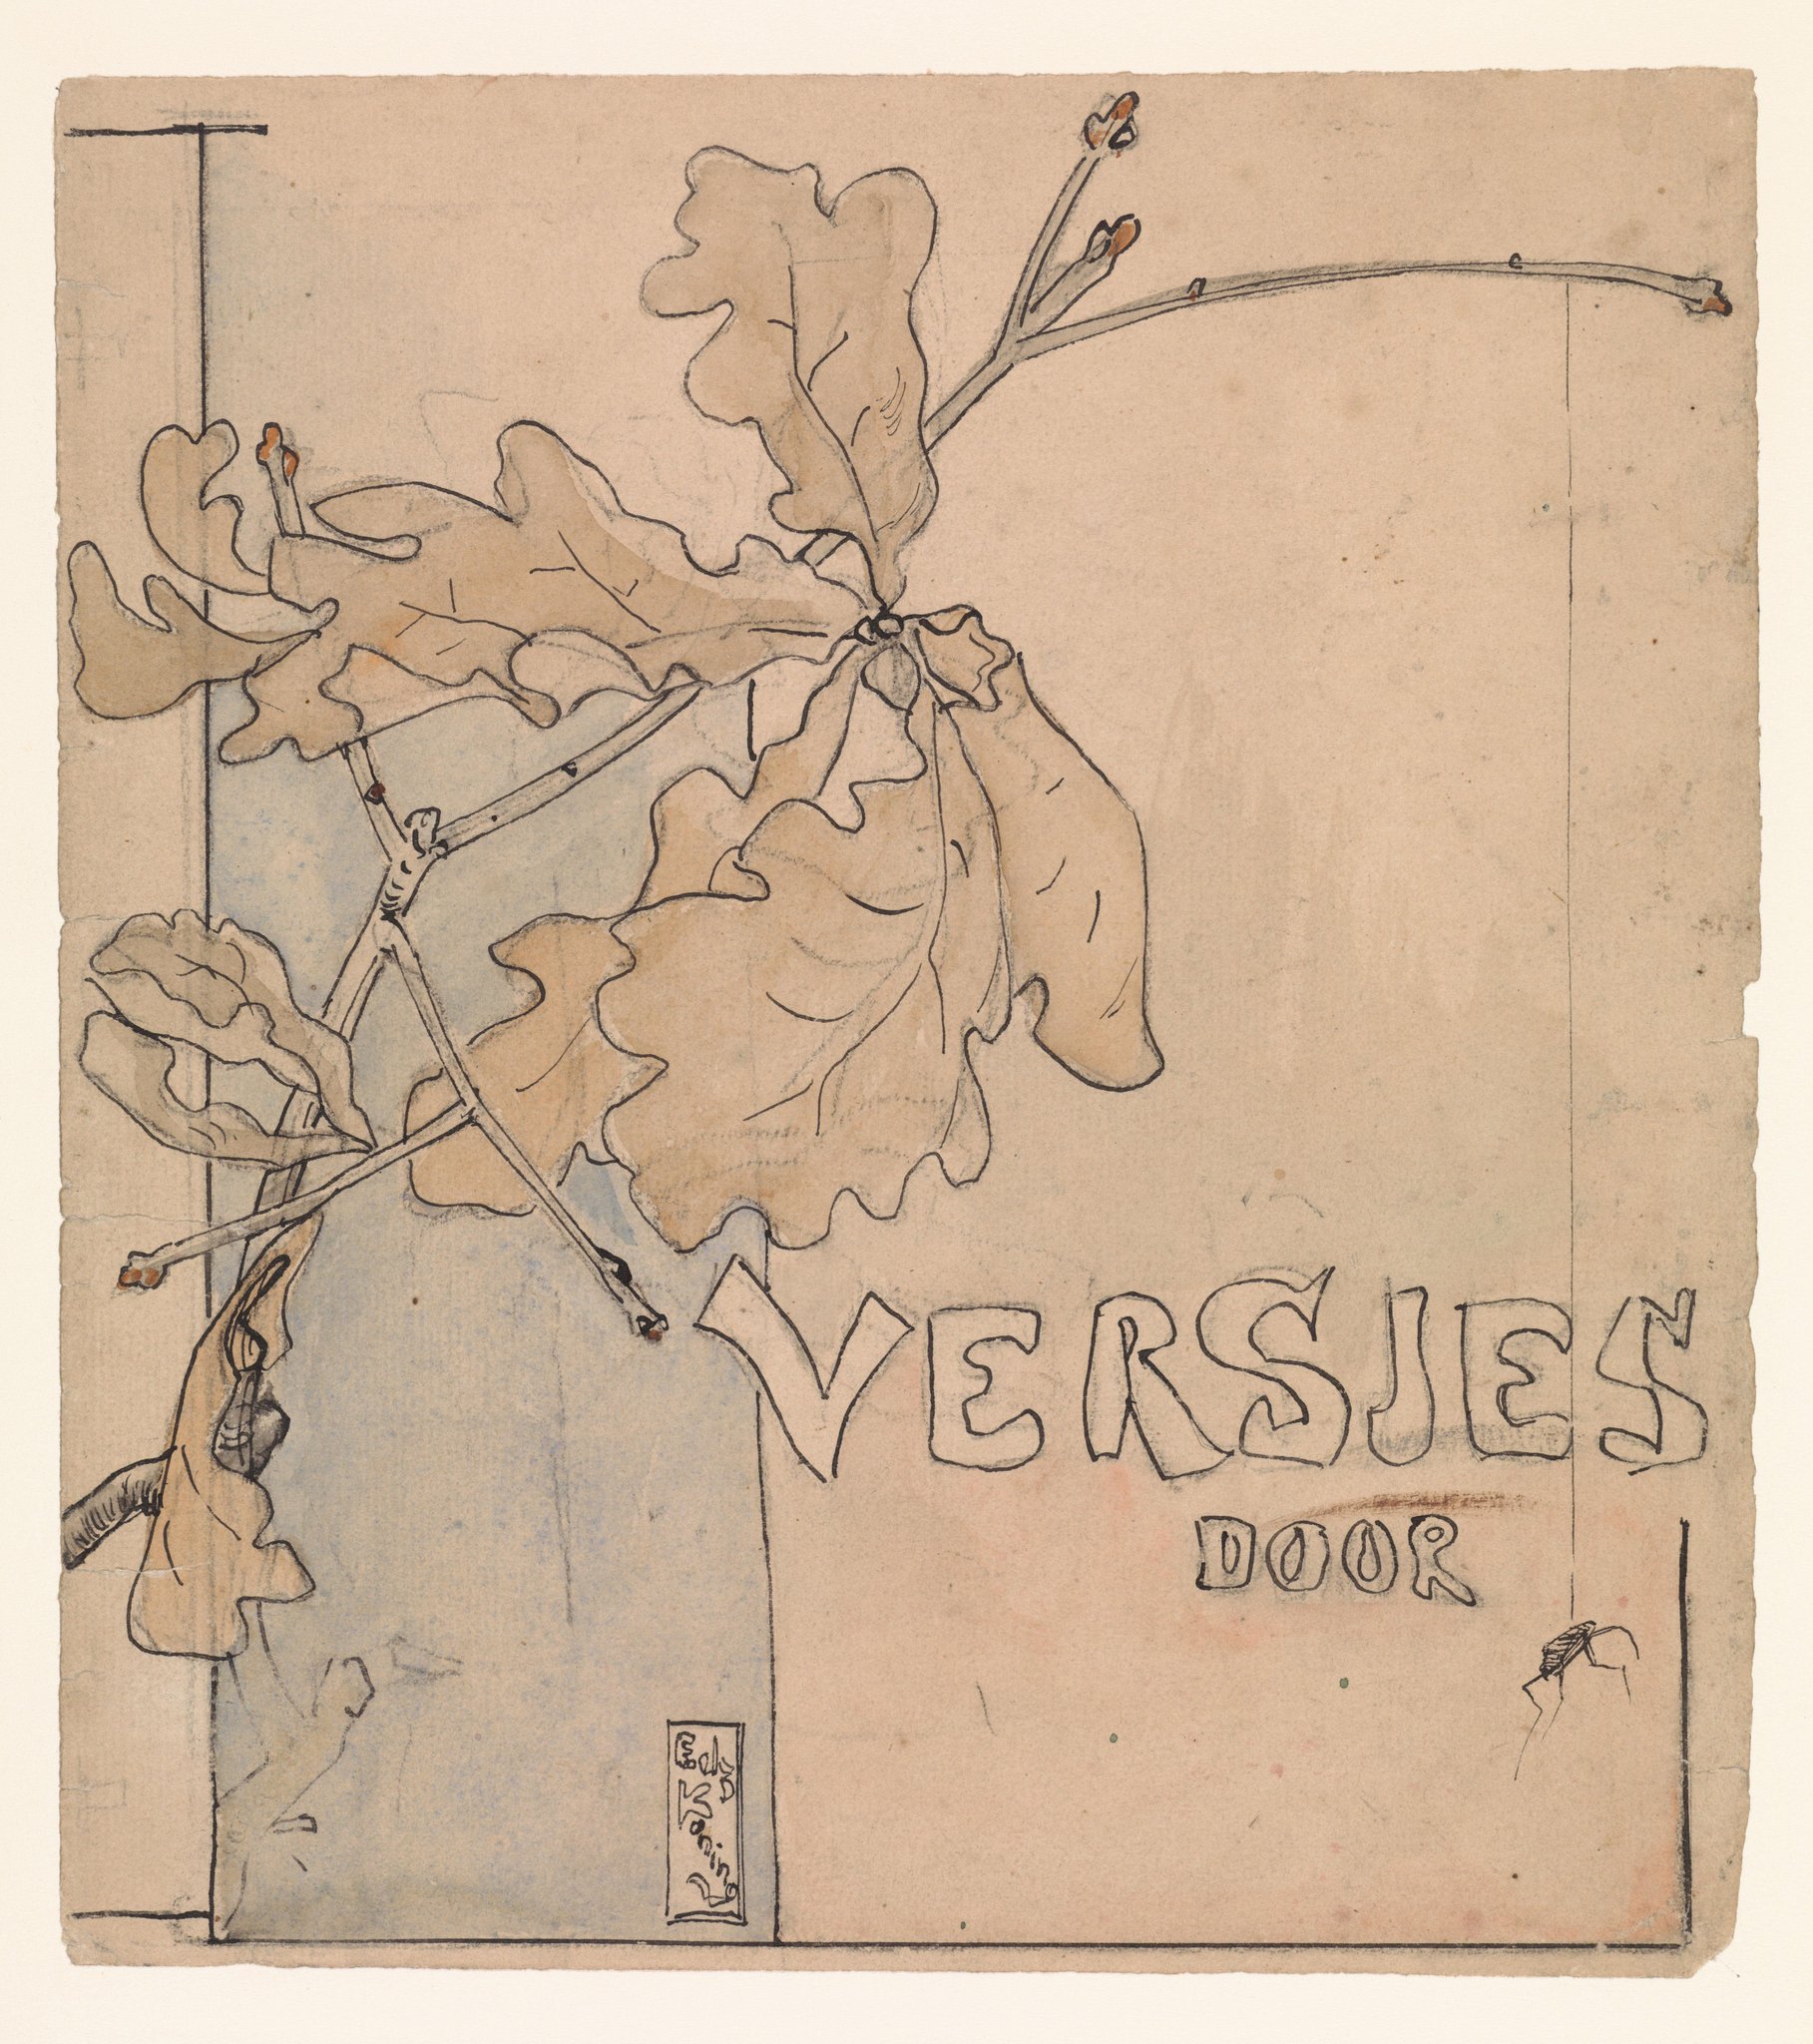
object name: design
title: Ontwerp voor omslag van album met eikenblad en spin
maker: edzard koning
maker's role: draughtsman, print maker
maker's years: 1869-1954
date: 1879-1954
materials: chalk, ink, paper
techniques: brush, pen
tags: (versjes) specific works of literature (with author, title), spiders, book-cover, binding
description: Ontwerp voor omslag voor een album 'Versjes'.